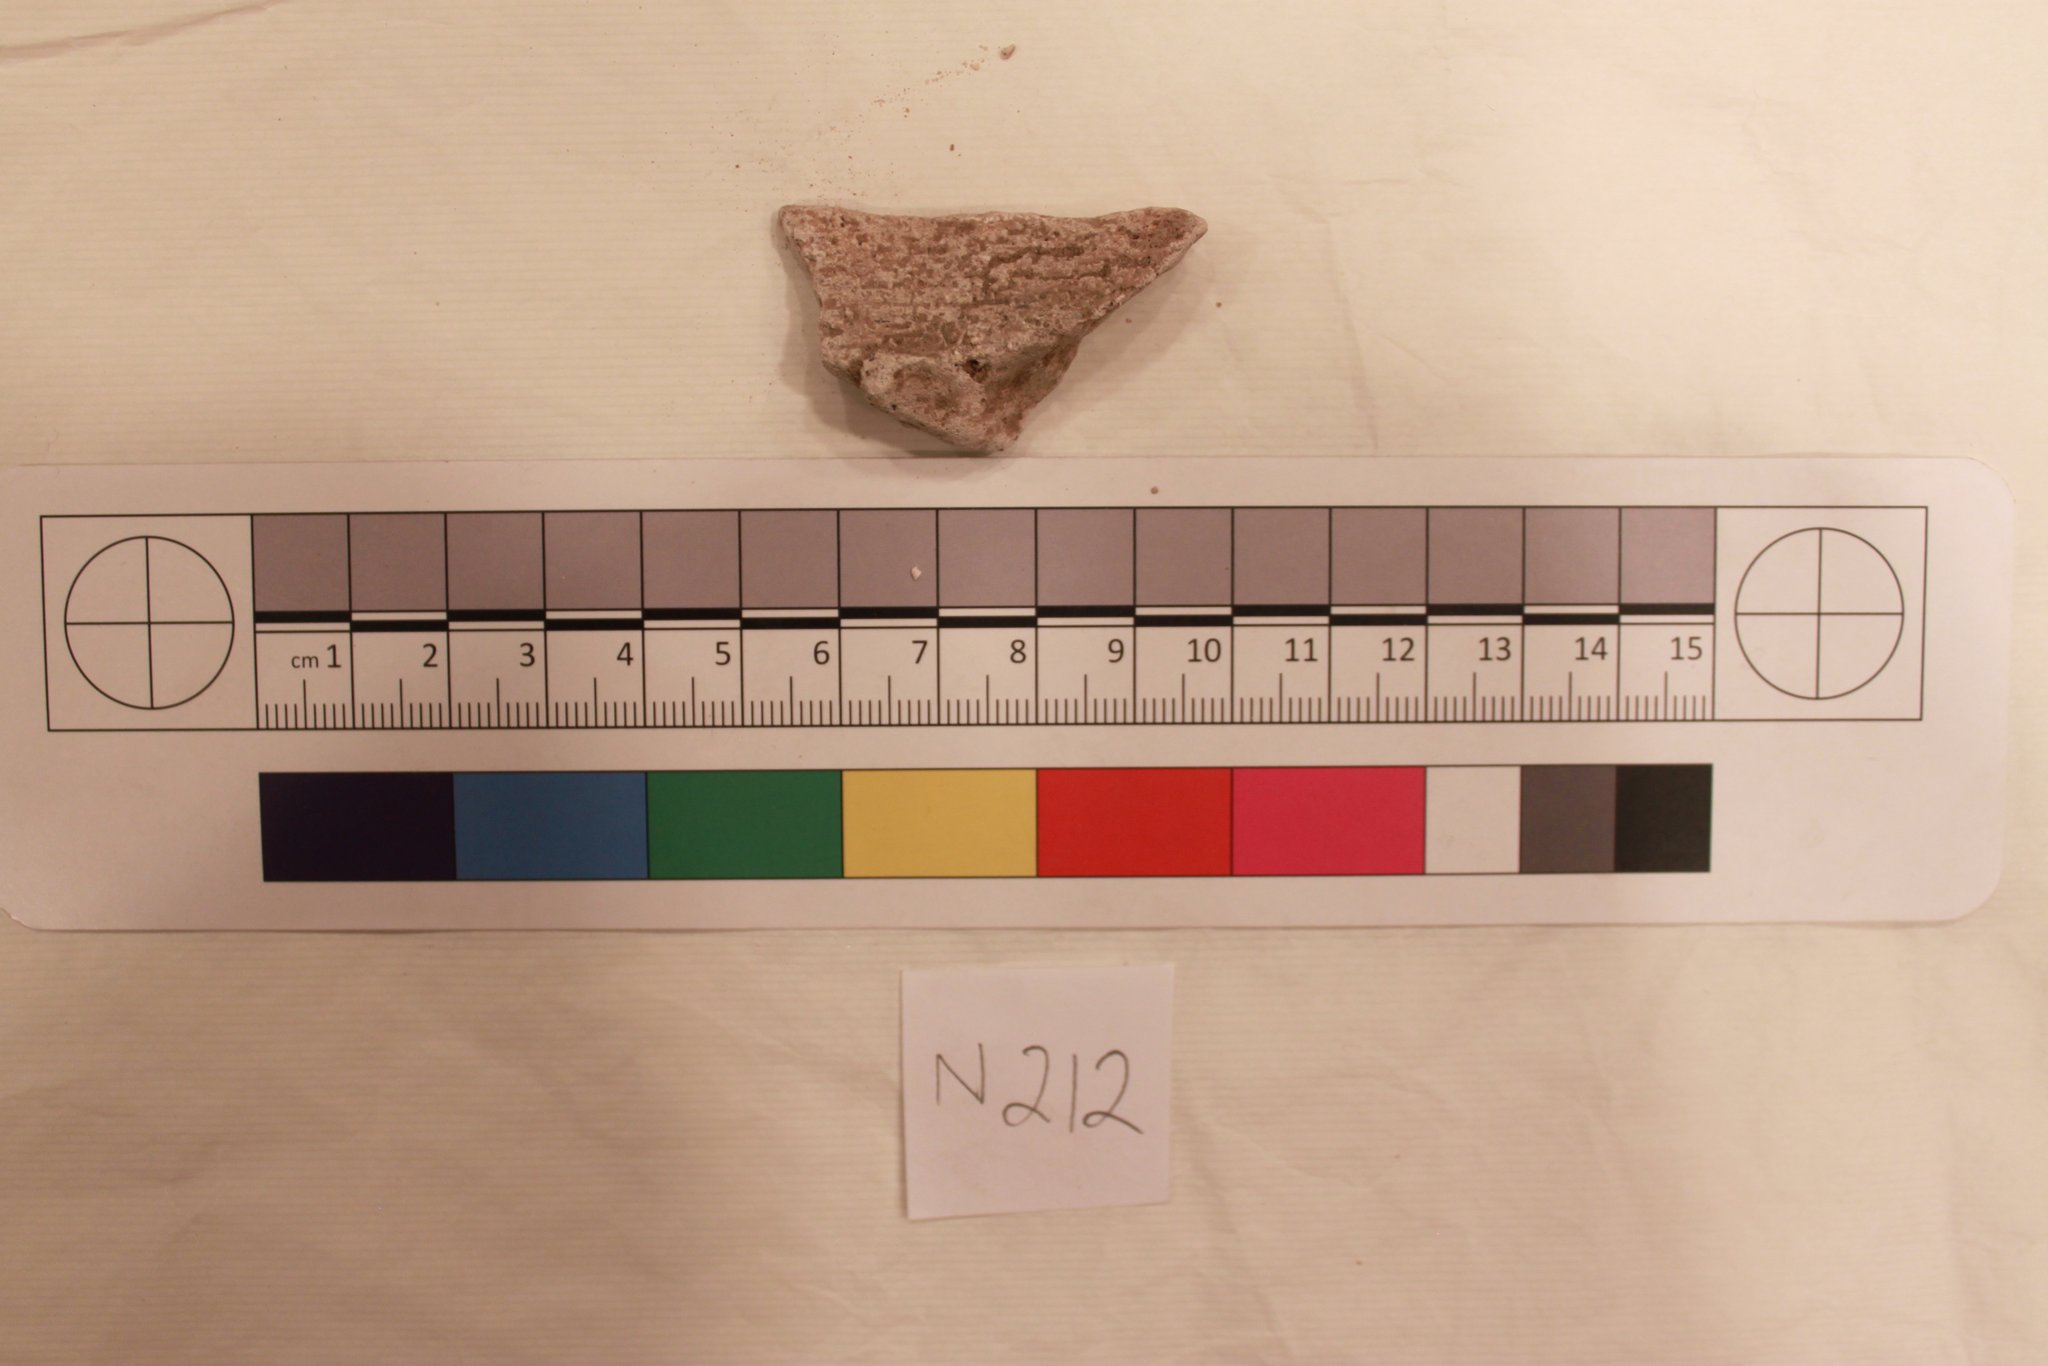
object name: fragment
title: Stucco Fragment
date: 701-1200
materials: plaster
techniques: carving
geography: iran